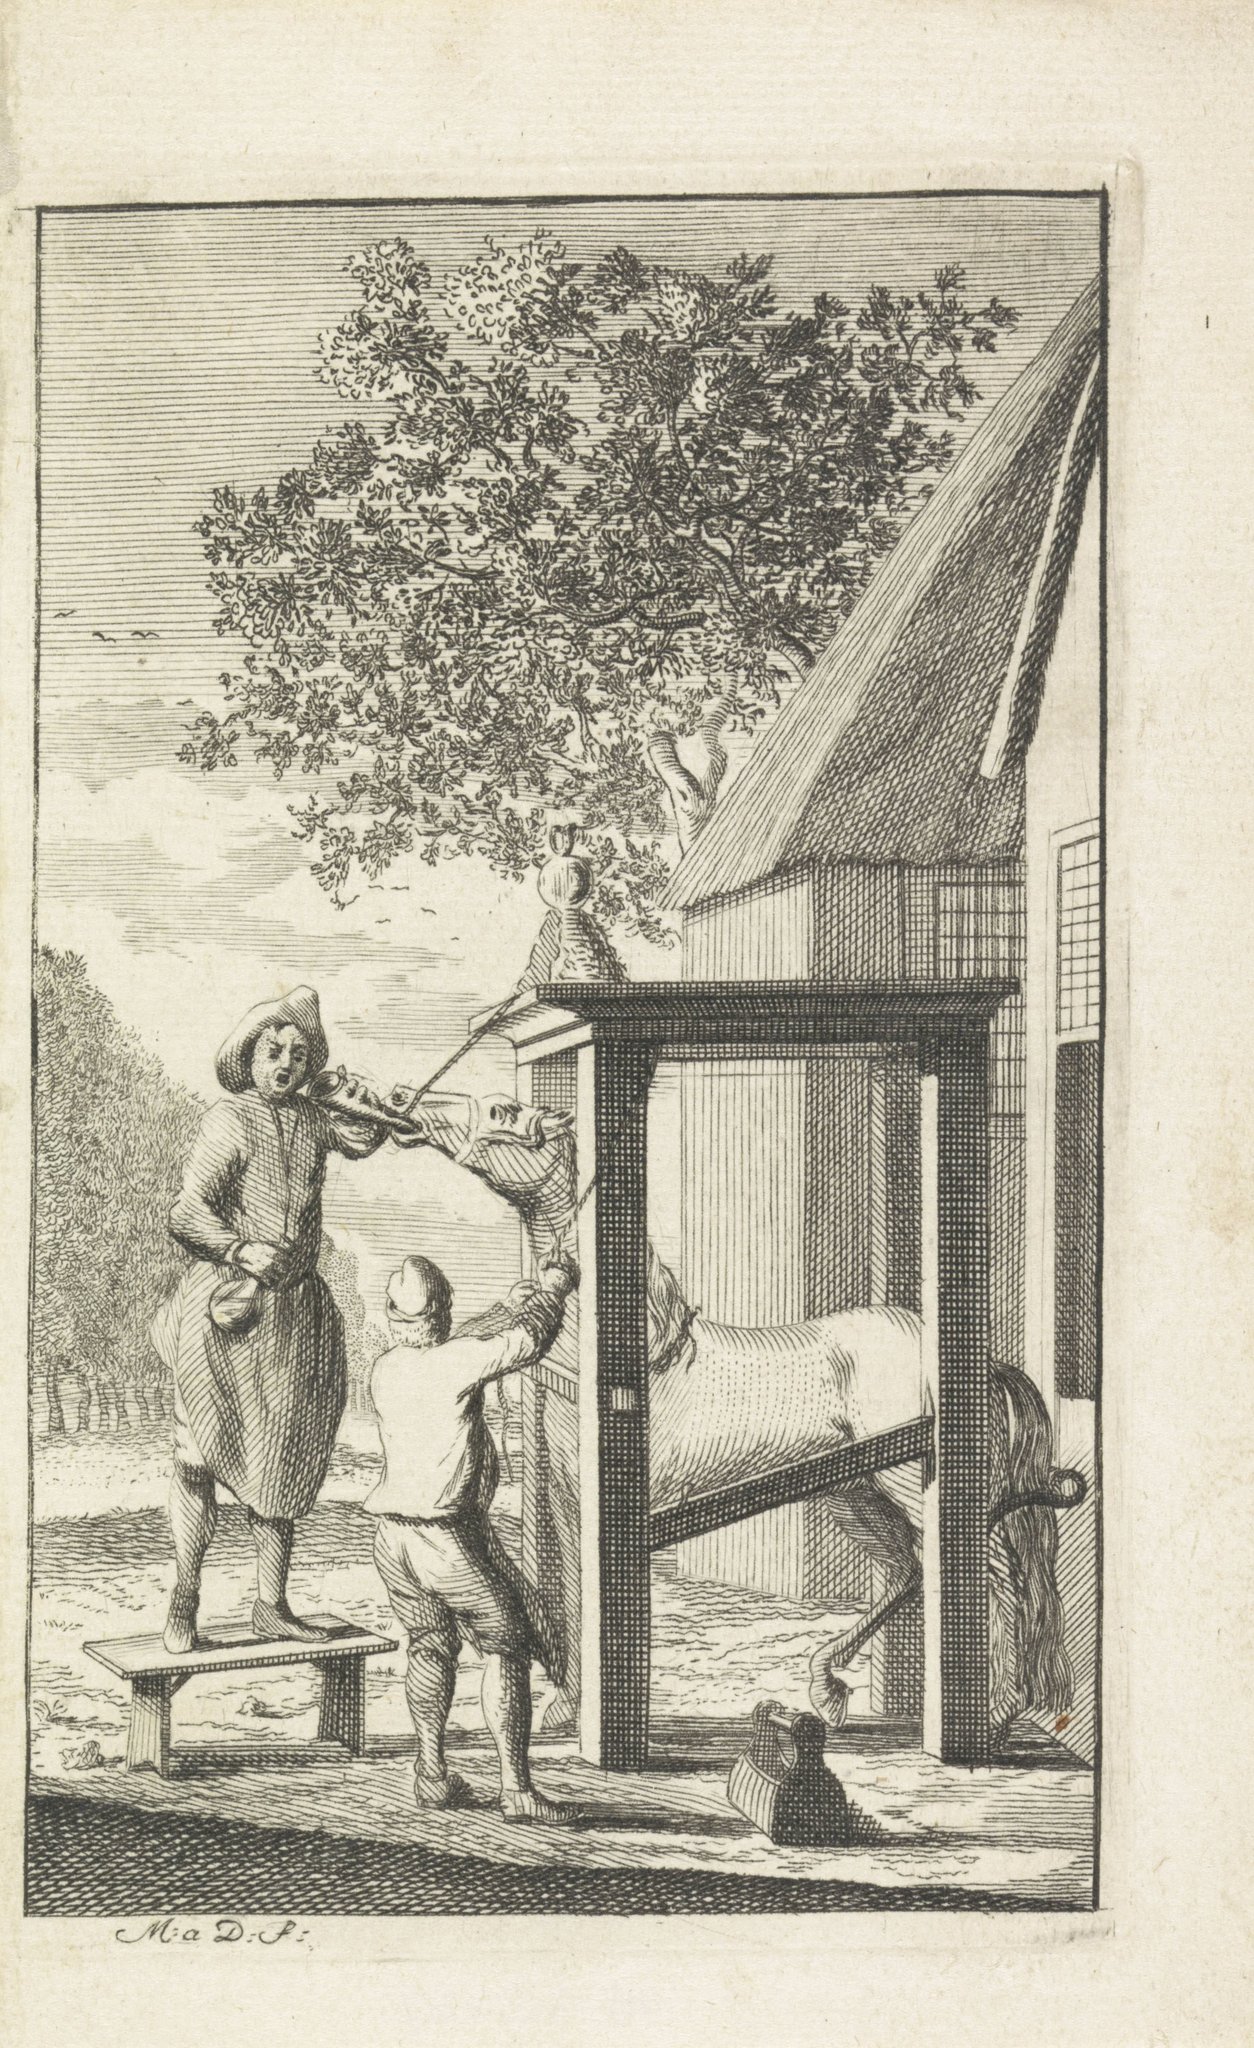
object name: print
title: Twee mannen verzorgen een paard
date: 1750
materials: paper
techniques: etching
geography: amsterdam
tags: horse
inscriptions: collector's mark: Lugt 2227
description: Boekillustratie uit: De volmaakte princelyke hoef-smidt, paerde-kooper en stal-meester. Amsterdam: Steven van Esveldt, 1750.